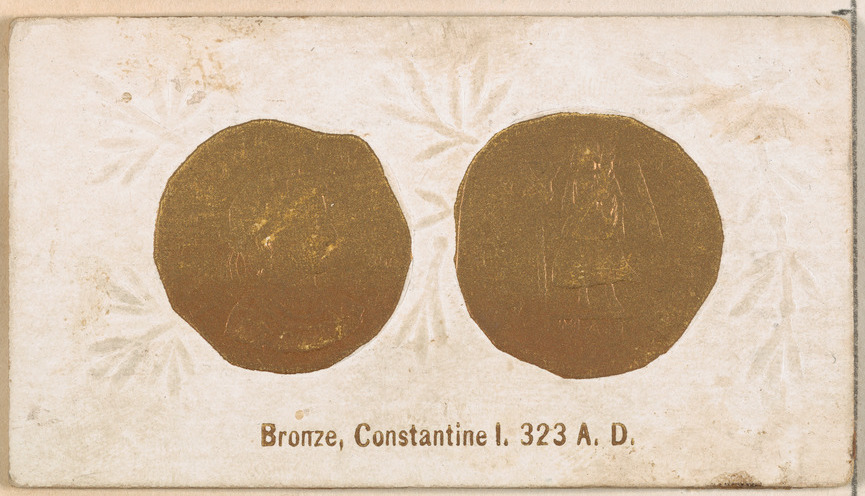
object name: print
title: Bronze, Constantine I, 323 A.D., from the Ancient Coins series (N180) issued by Wm. S. Kimball & Co.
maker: william s. kimball & company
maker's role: publisher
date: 1888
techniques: color lithograph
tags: coins